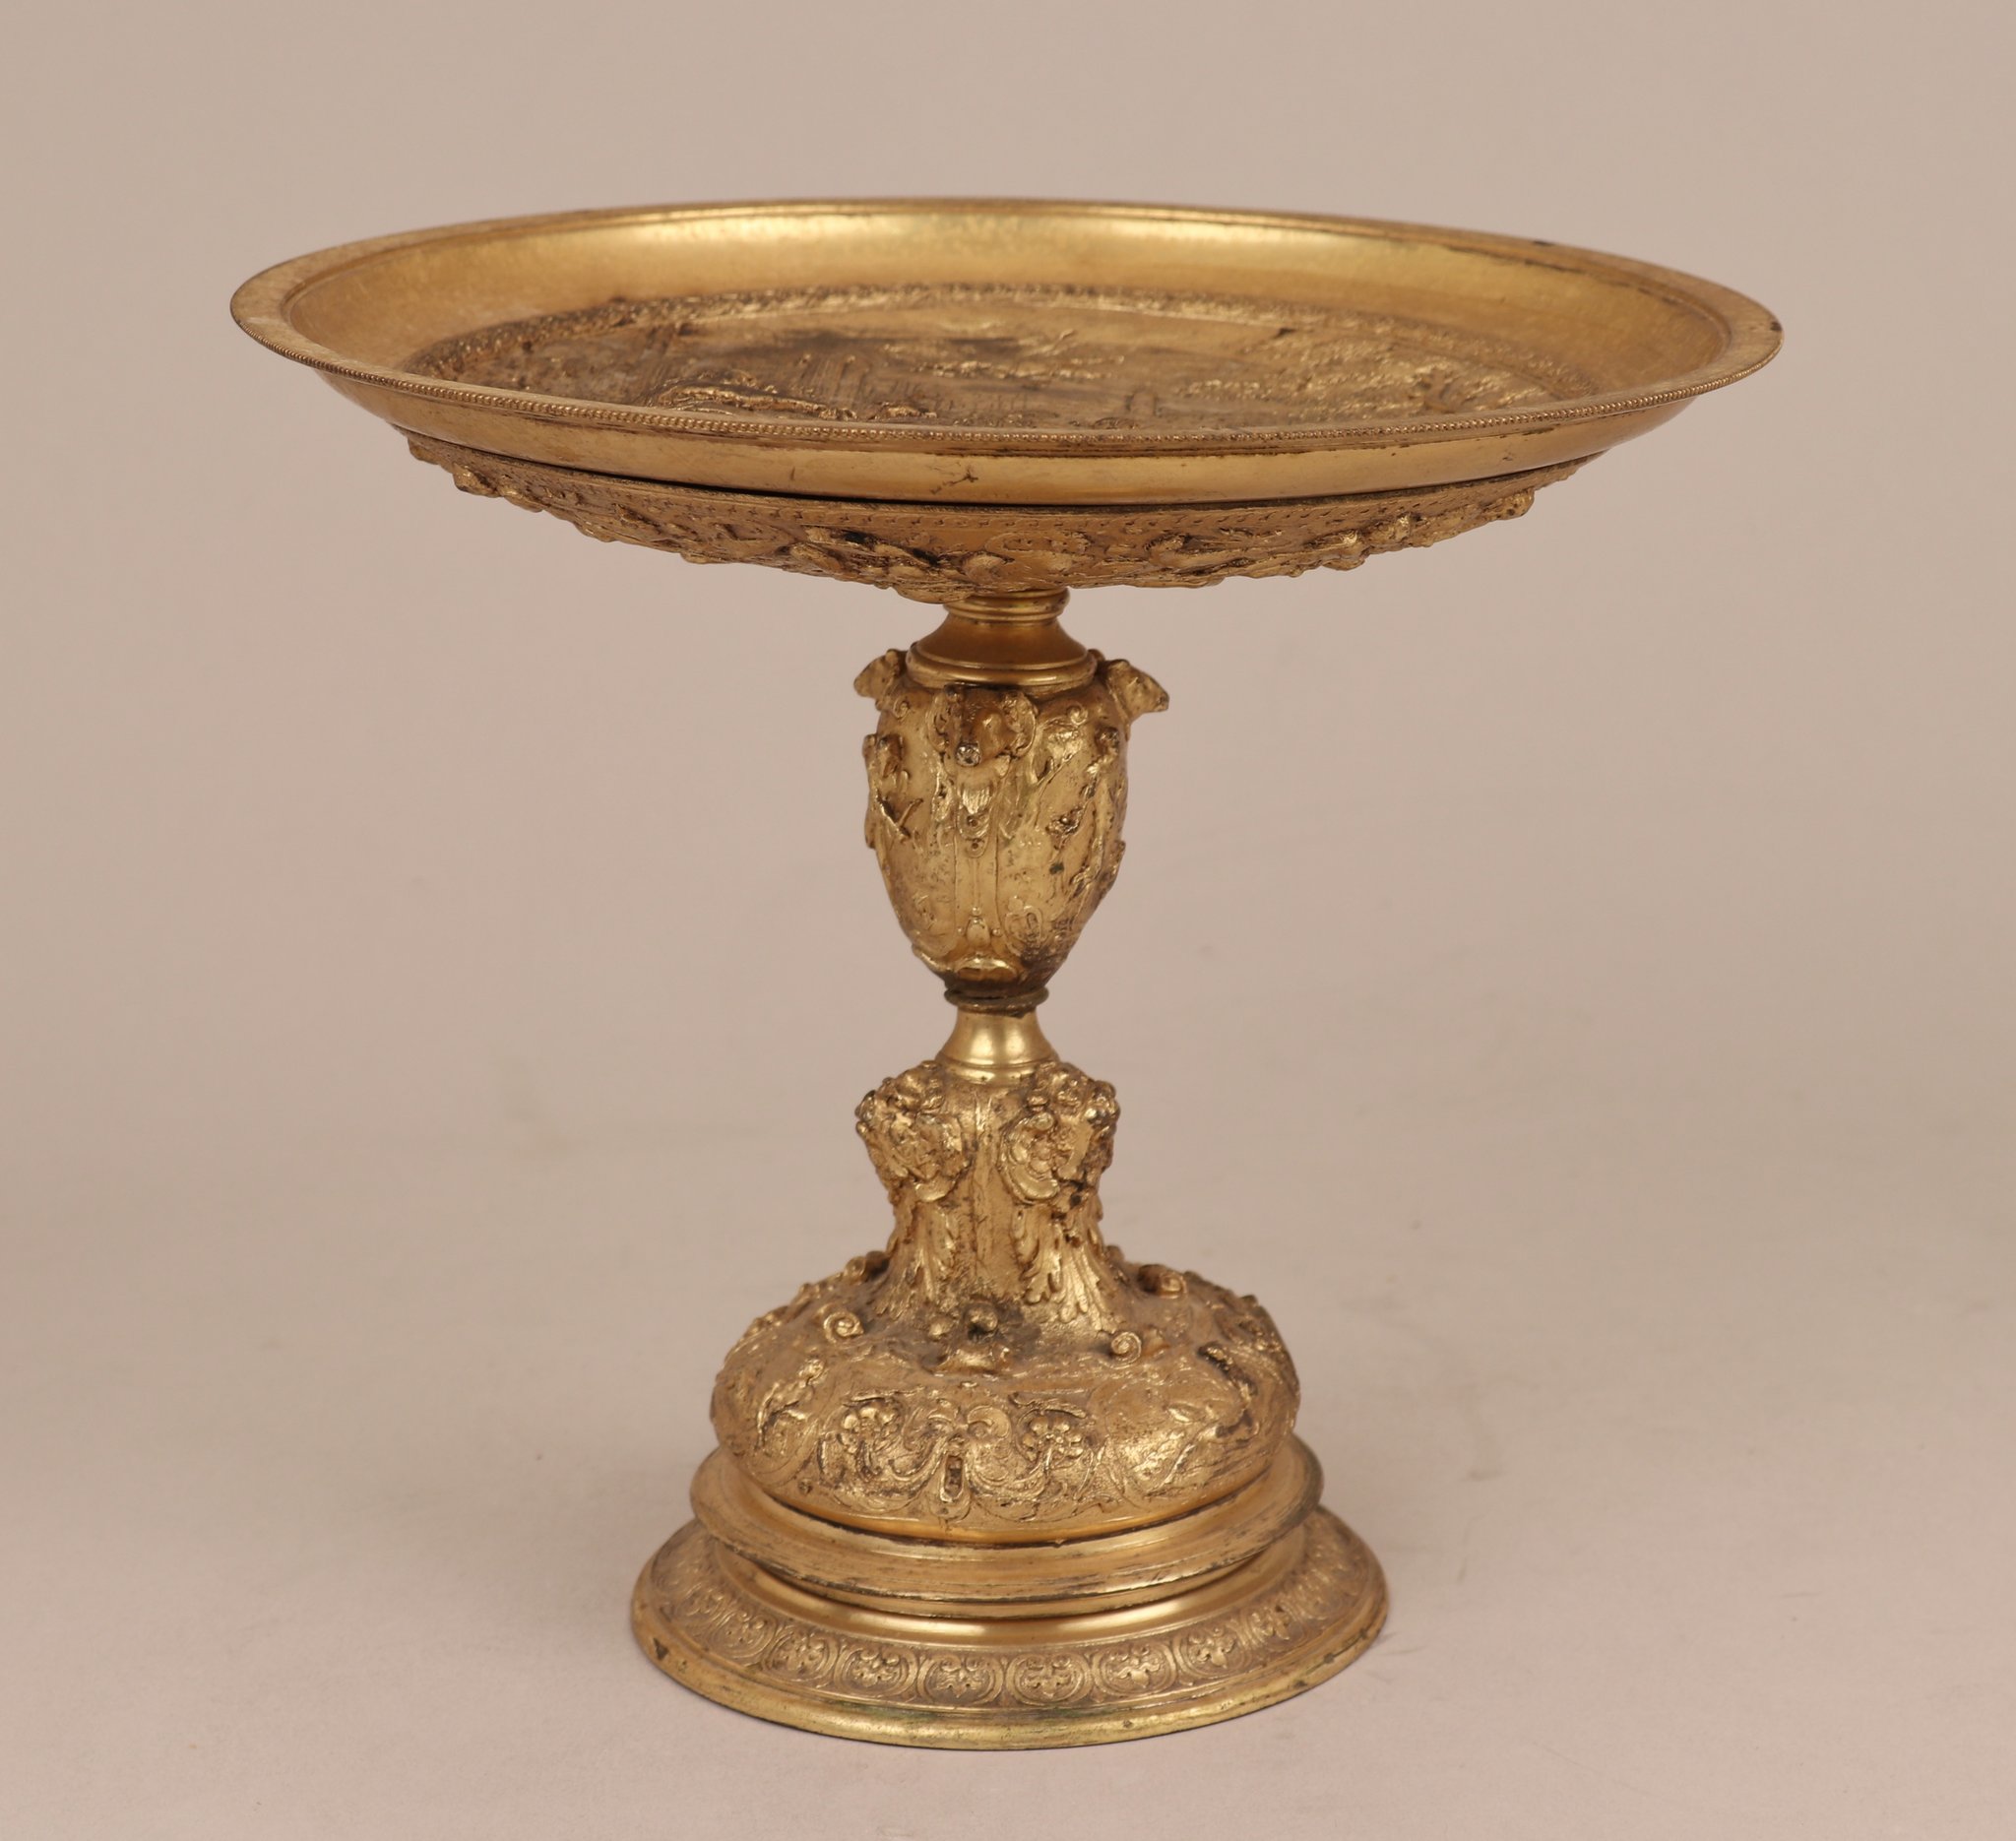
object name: tazza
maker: benvenuto cellini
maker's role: artist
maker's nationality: italian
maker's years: 1500-1571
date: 1801-1900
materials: silver gilt